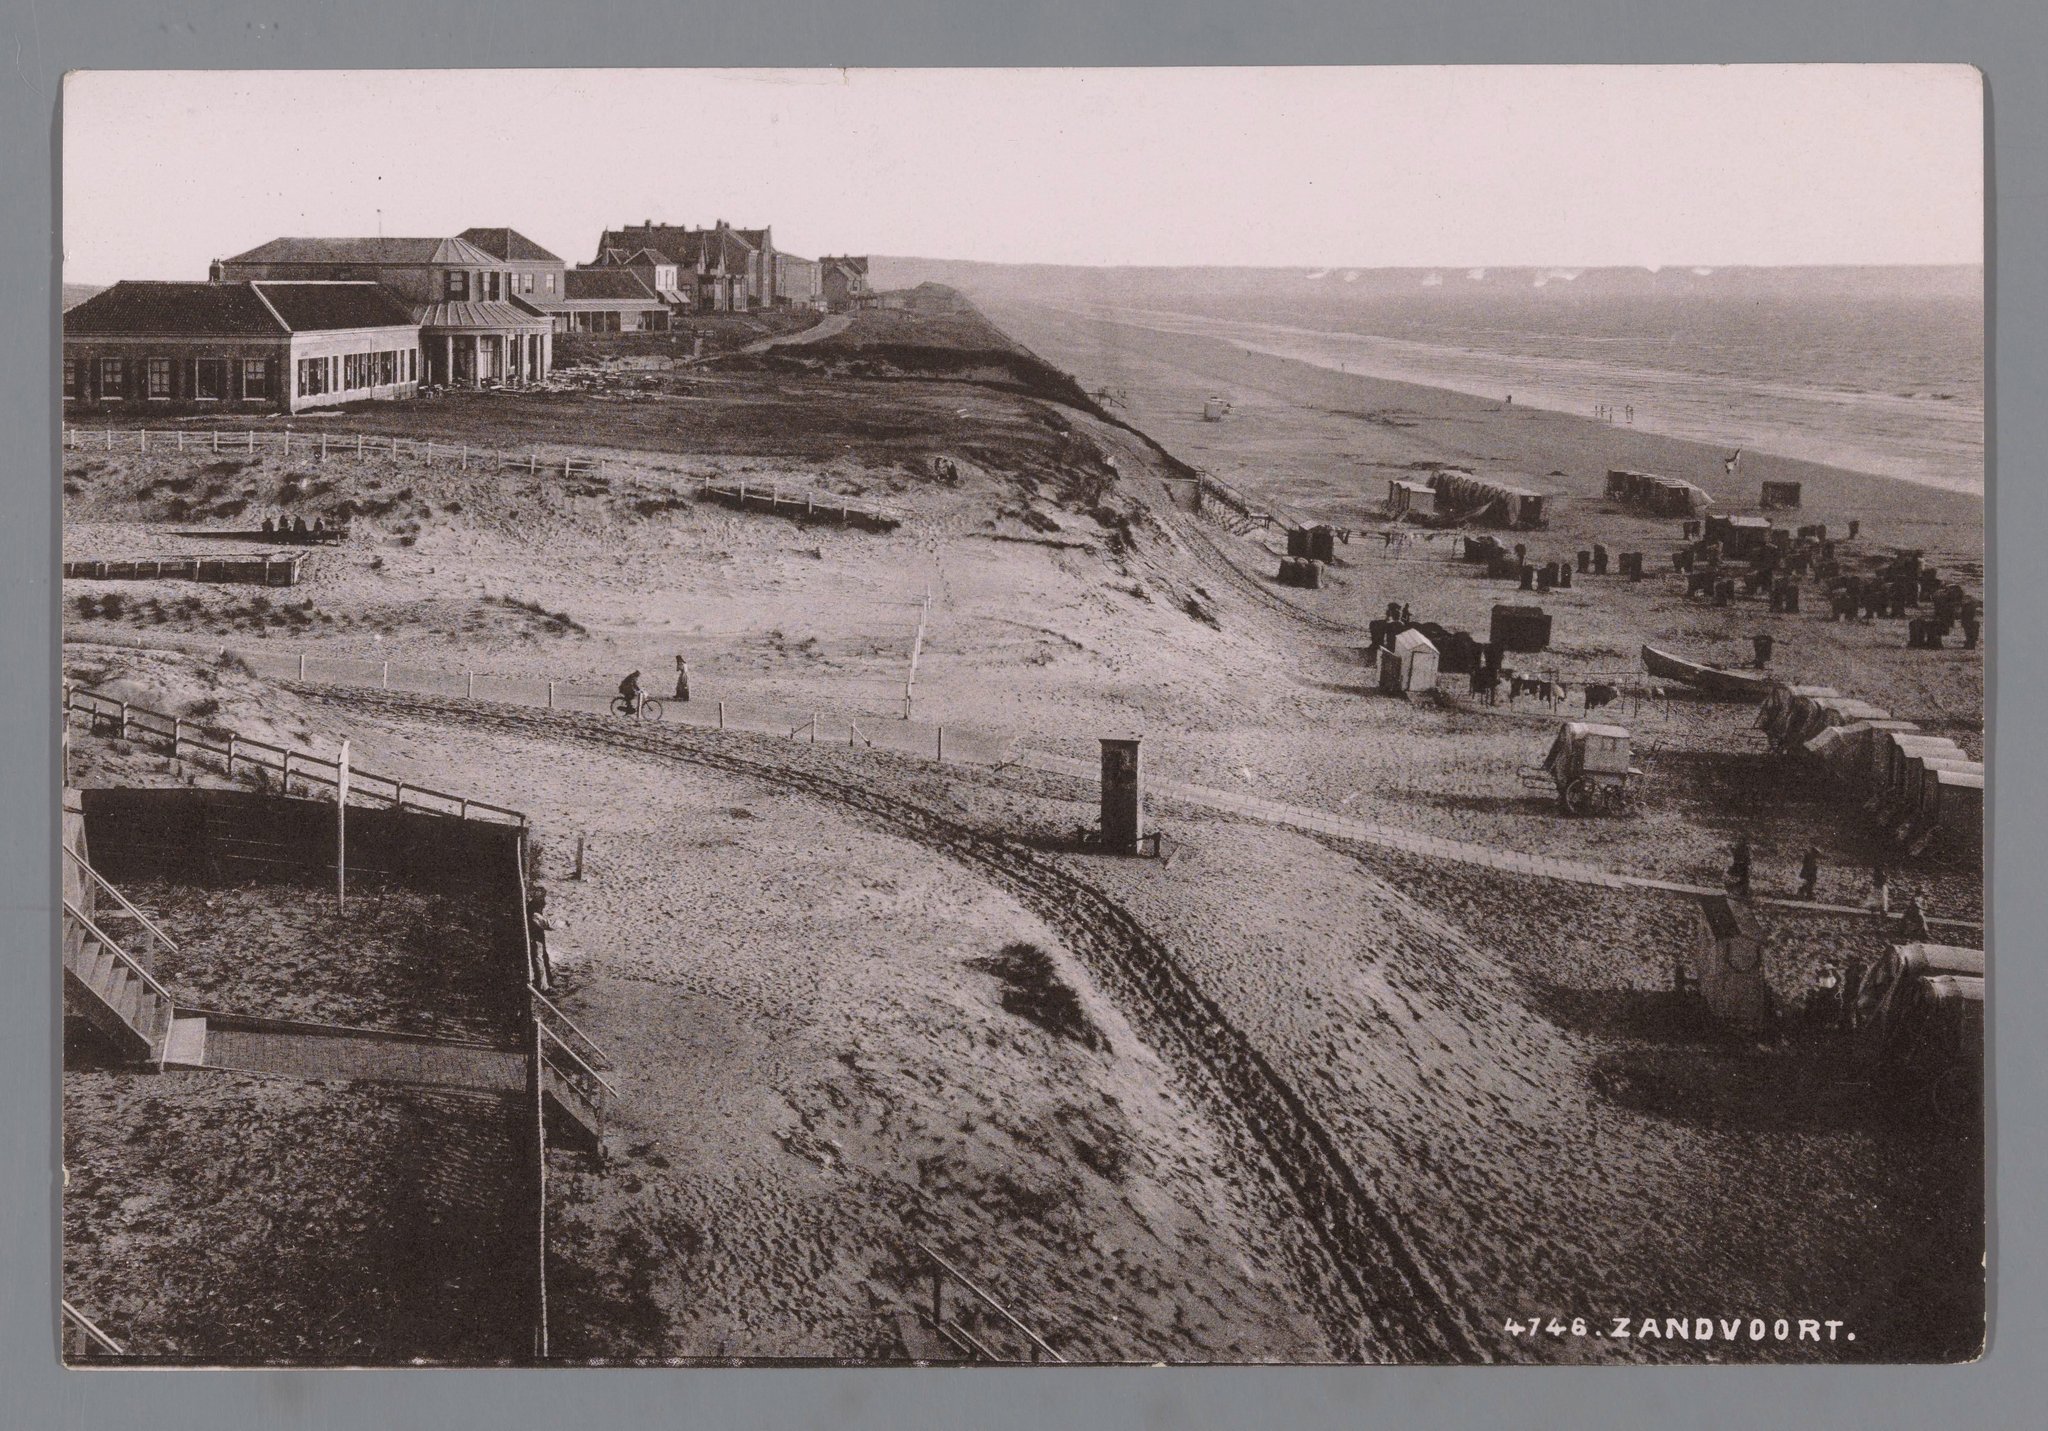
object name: photomechanical print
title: Gezicht op het strand te Zandvoort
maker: Anonymous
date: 1880-1920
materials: paper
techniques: photograph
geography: zandvoort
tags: beach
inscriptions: retailer's mark: ‘Boek-, Papier, Muziekhandel/ en aanverwante artikelen/ H. Goebergh/ Grote Houtstraat/ Haarlem’